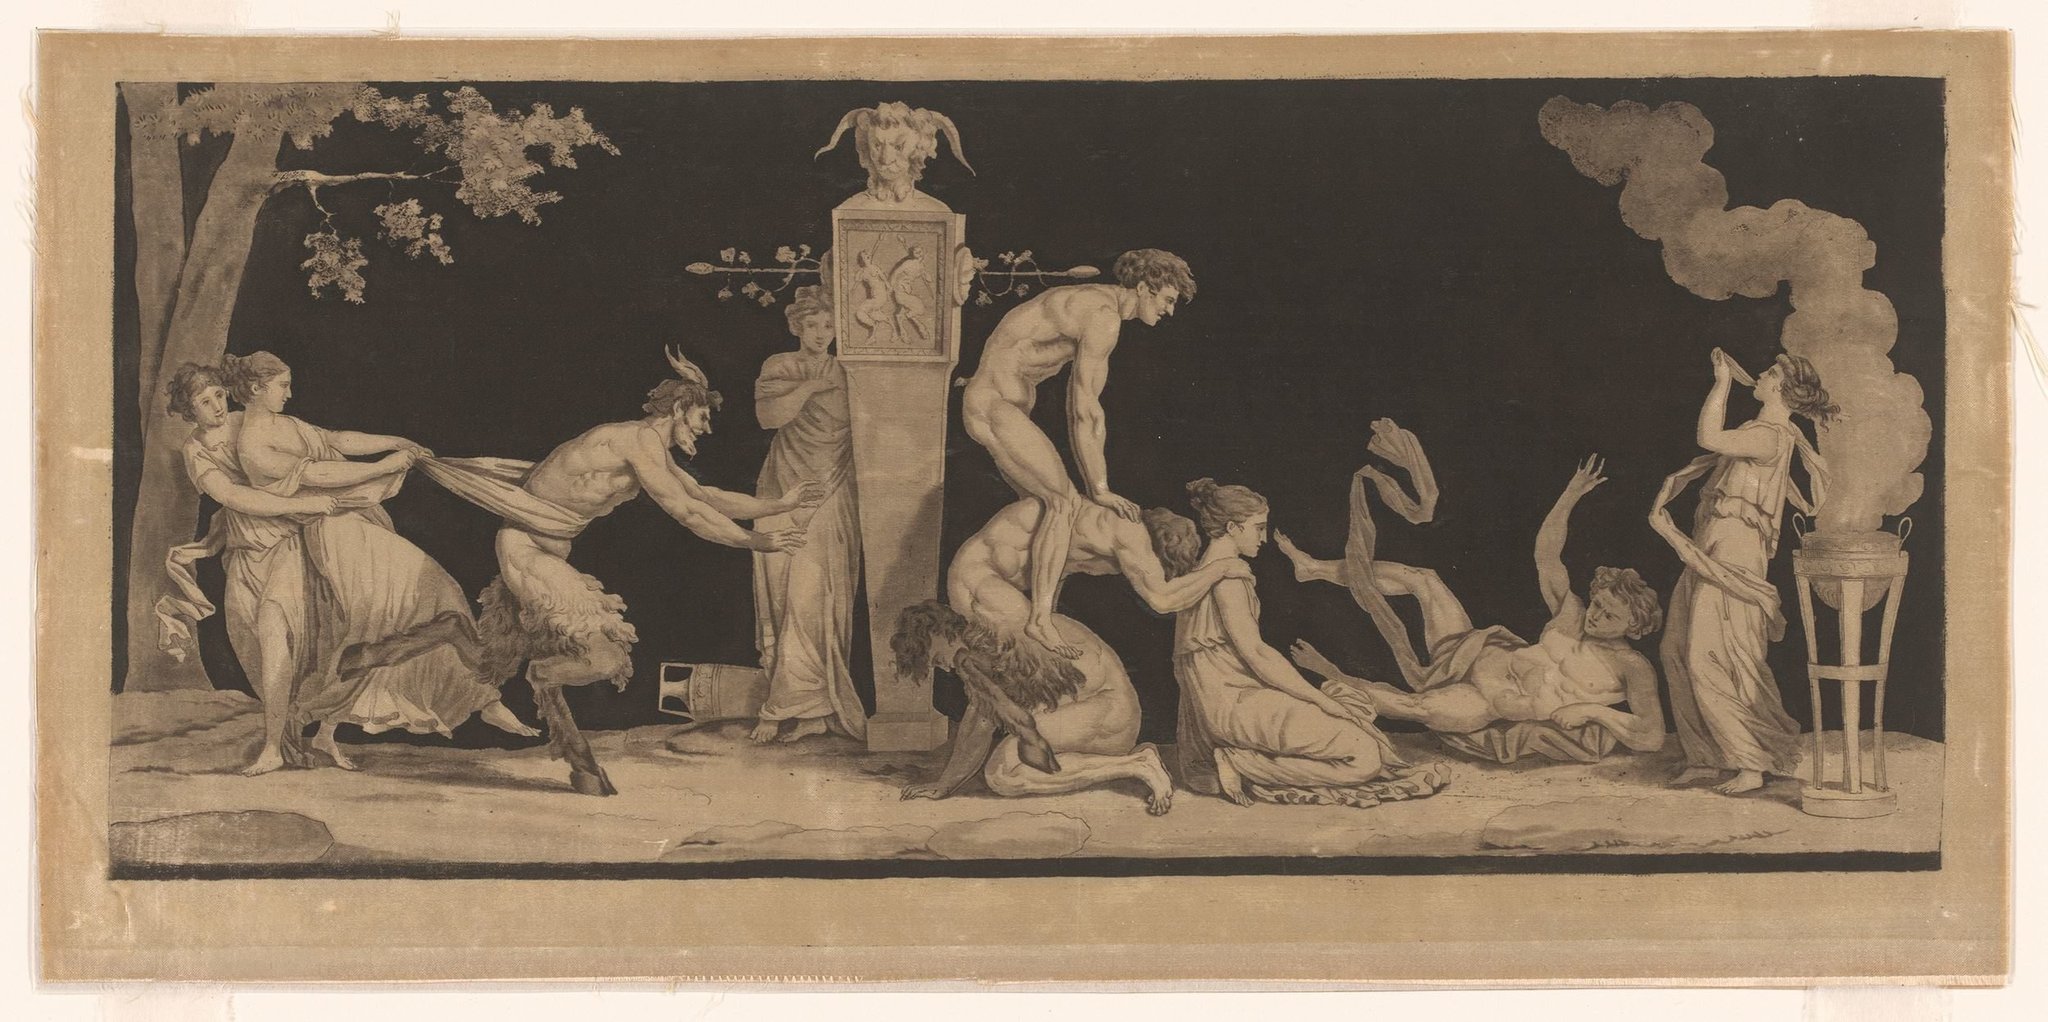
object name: print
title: Bacchanaal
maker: laurent guyot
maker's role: print maker, publisher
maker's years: 1756-1806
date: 1766-1806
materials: ink, textile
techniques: brush, etching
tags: satyrs, fauns, sileni, types of nymphs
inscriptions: collector's mark: Lugt 2228, collector's mark: Lugt 2760